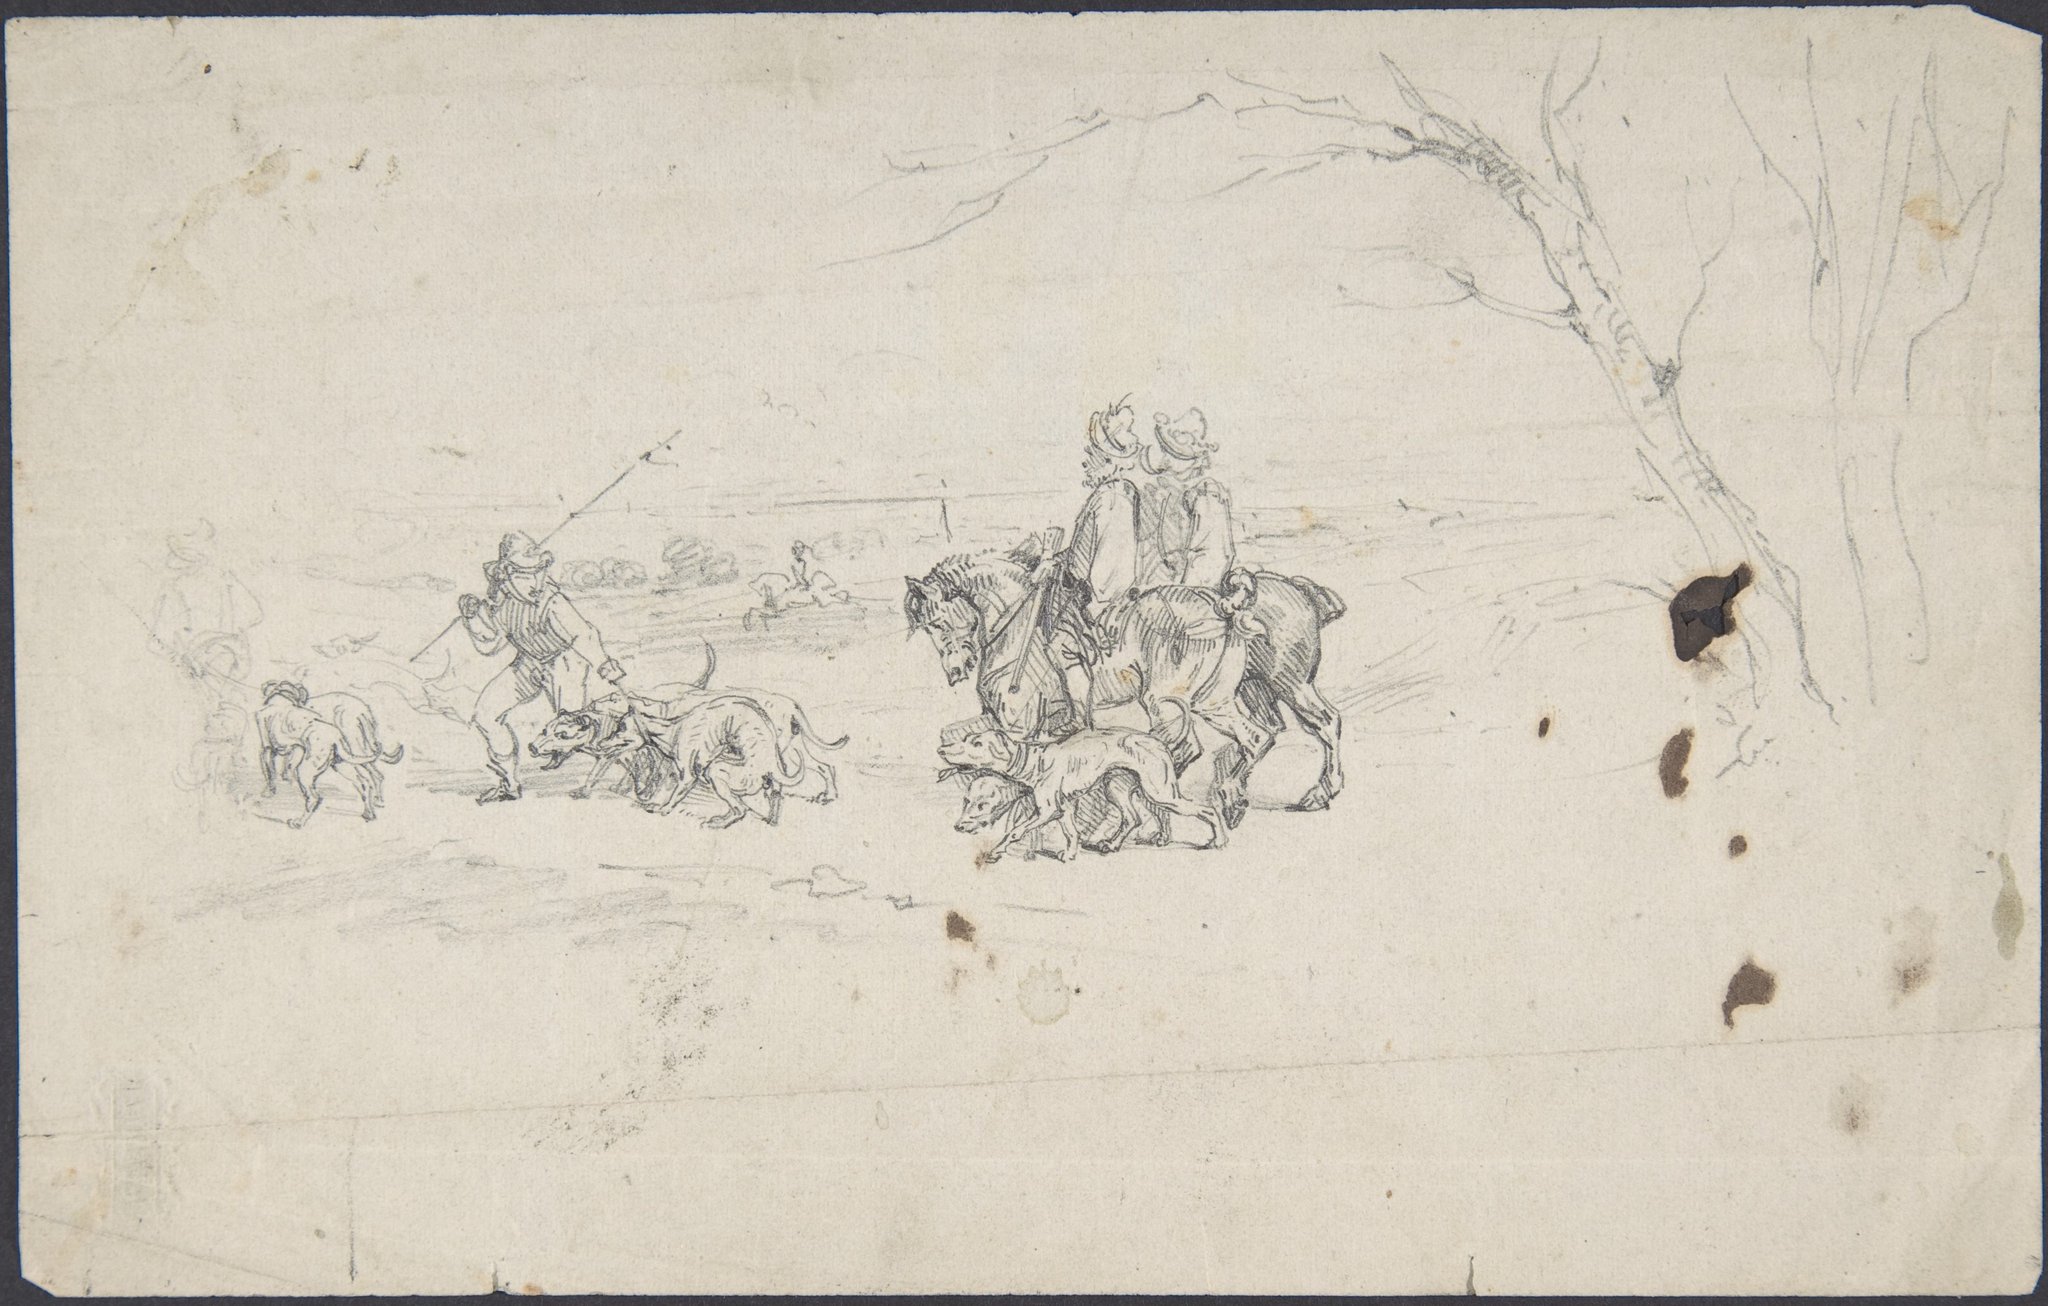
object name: drawing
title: Sketch of horsemen with dogs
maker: anonymous, german, 19th century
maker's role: artist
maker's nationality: german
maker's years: 1800-1899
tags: men,dogs,horses